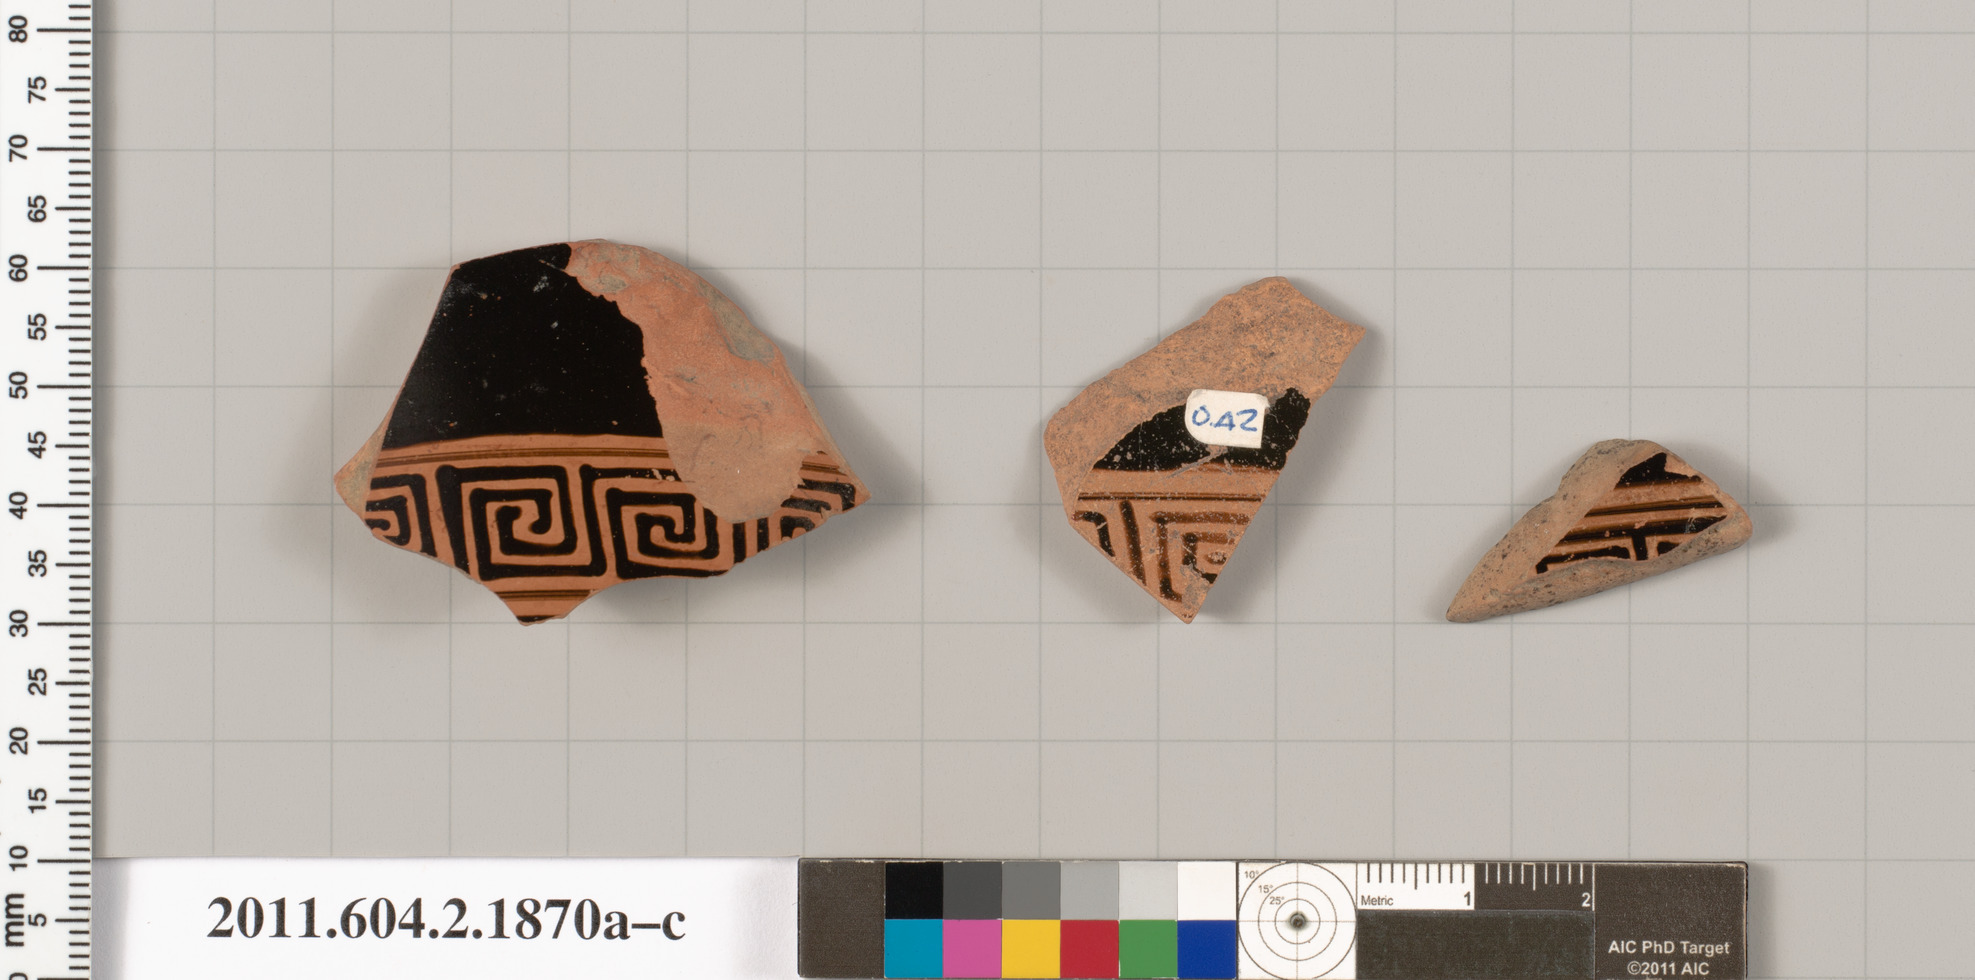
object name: skyphos fragment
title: Terracotta fragments of skyphoi (deep drinking cups)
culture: greek, attic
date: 470-440 BCE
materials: terracotta